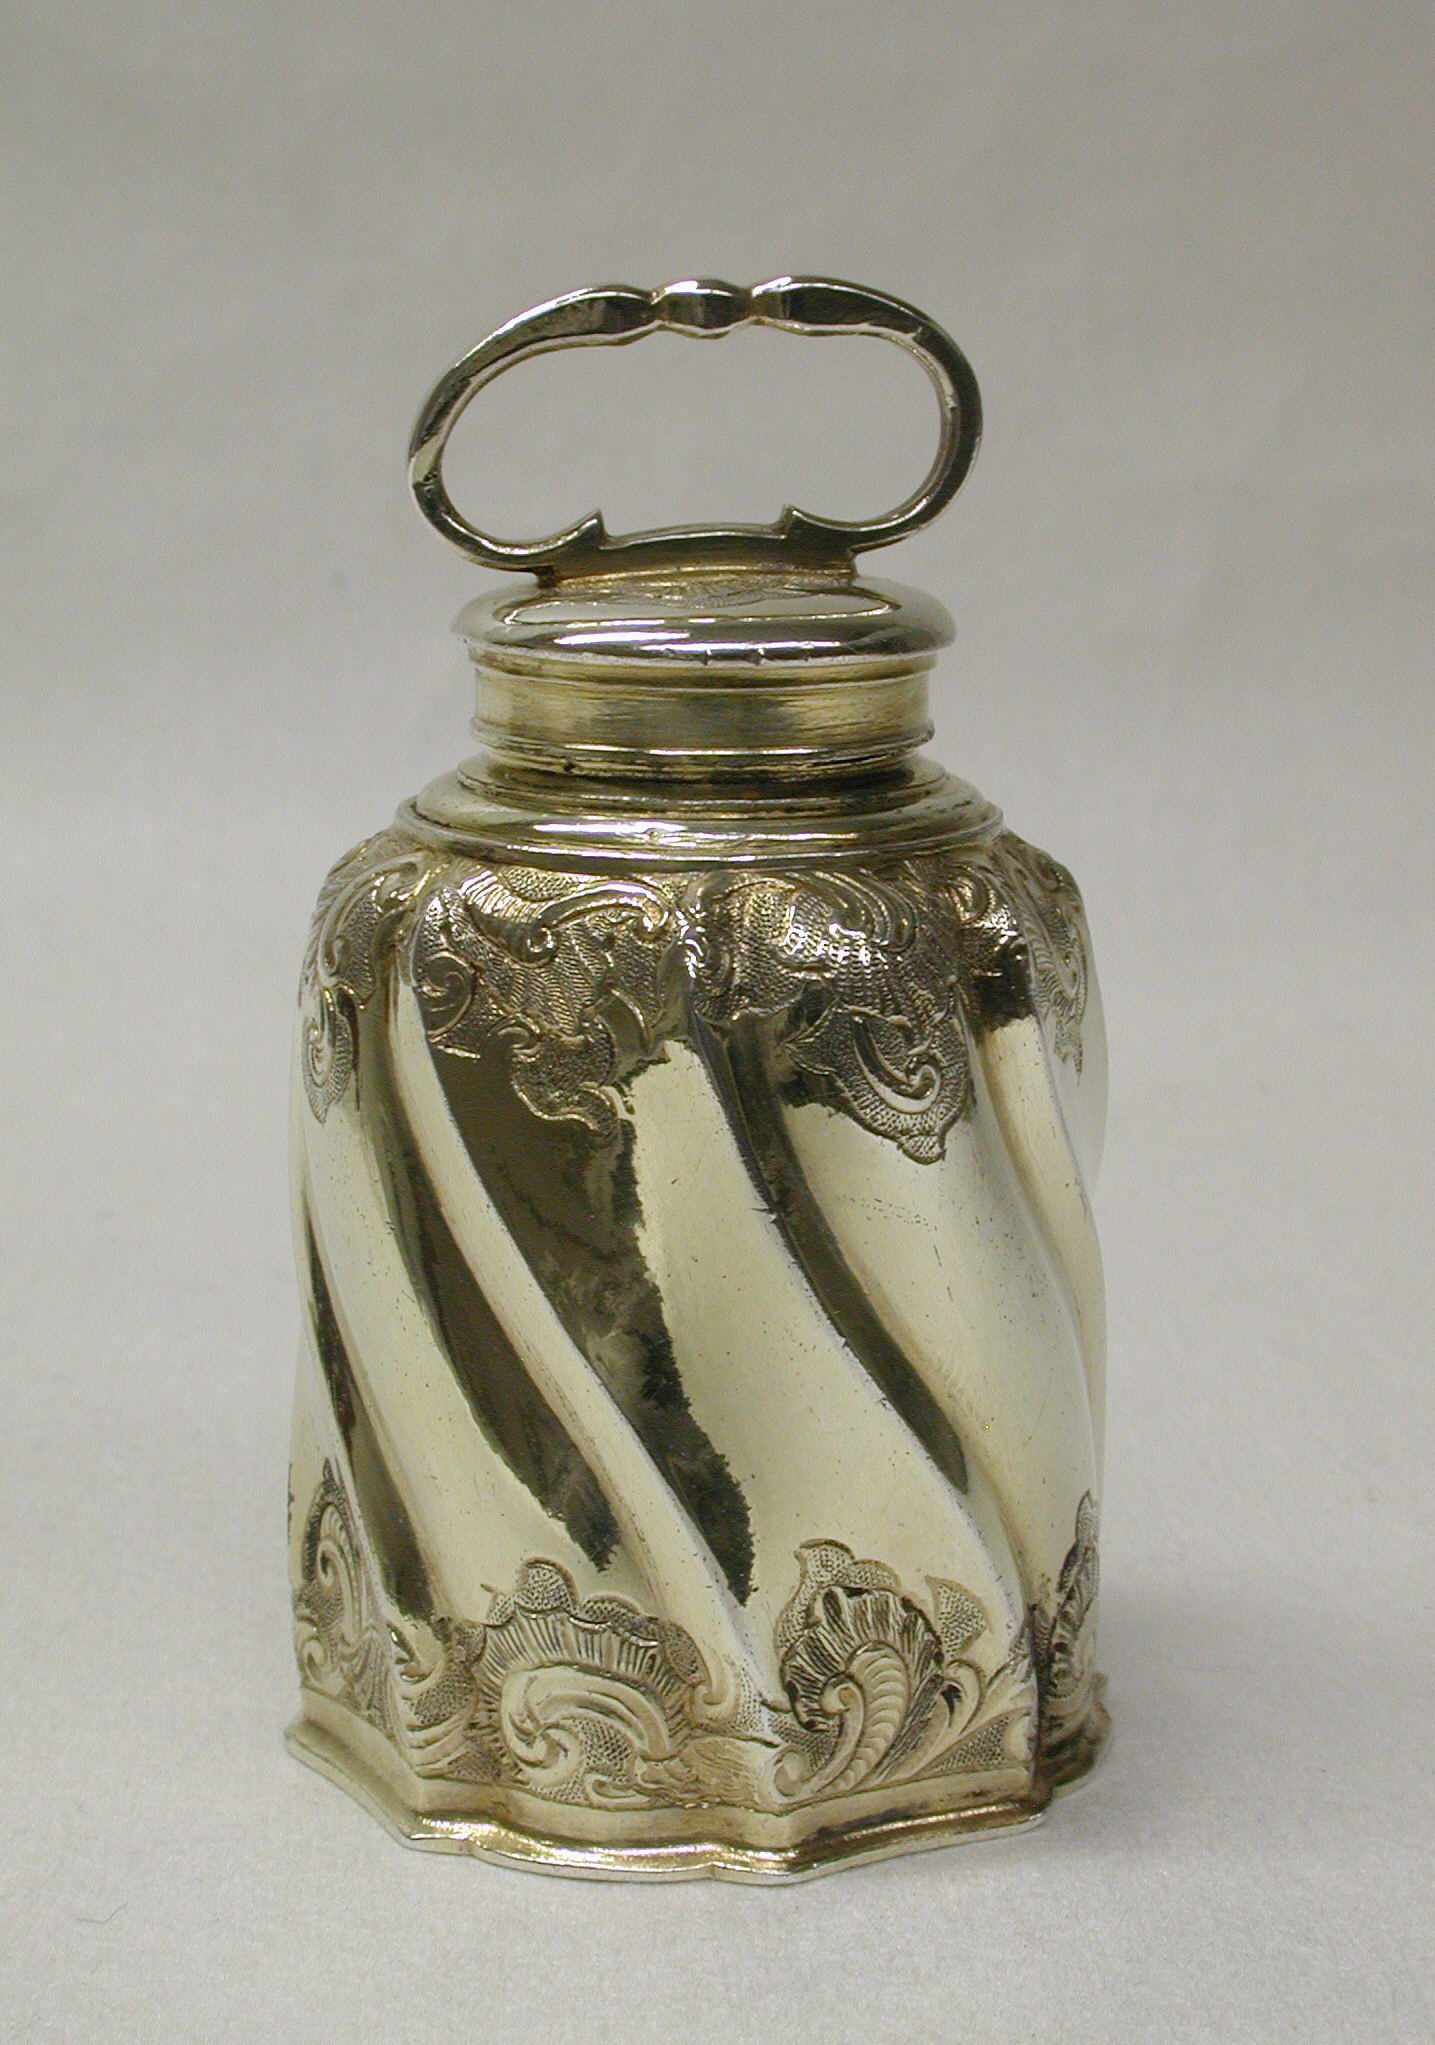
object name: canister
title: Screw-top canister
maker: friedrich schwestermuller ii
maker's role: maker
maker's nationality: german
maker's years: 1713-1752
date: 1743-1745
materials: silver gilt